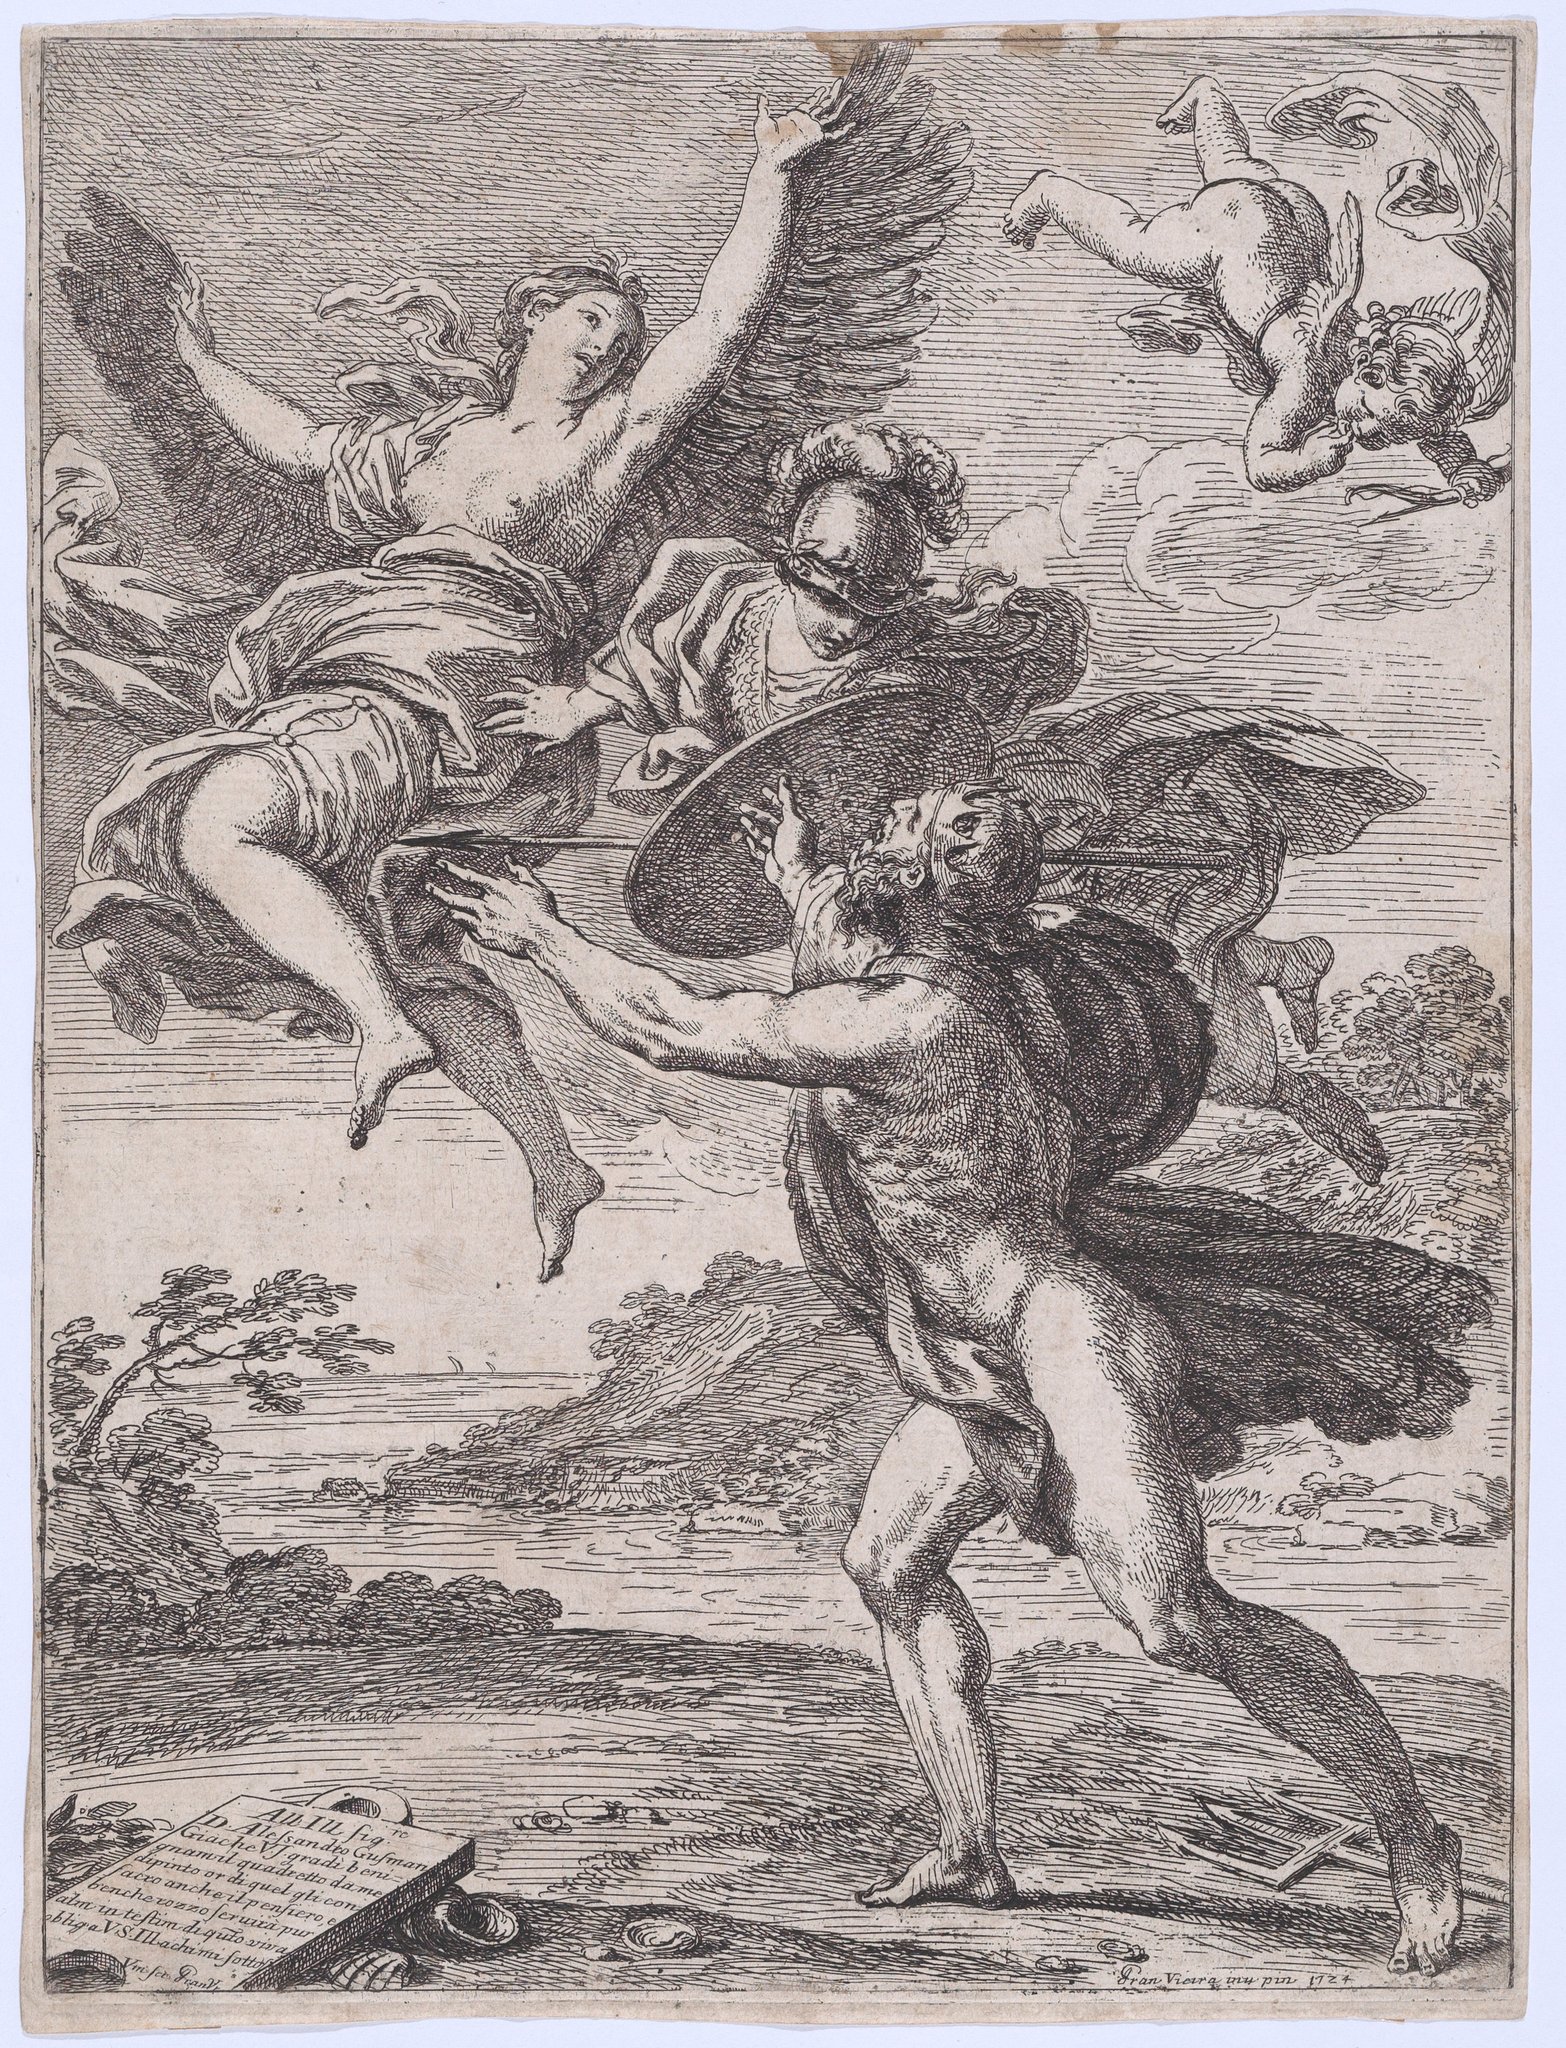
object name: print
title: Neptune pursuing Coronis; Minerva interposes herself and turns Coronis into a crow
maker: francisco vieira de mattos (il lusitano)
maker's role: artist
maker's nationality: portuguese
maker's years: 1699-1783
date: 1724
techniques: etching